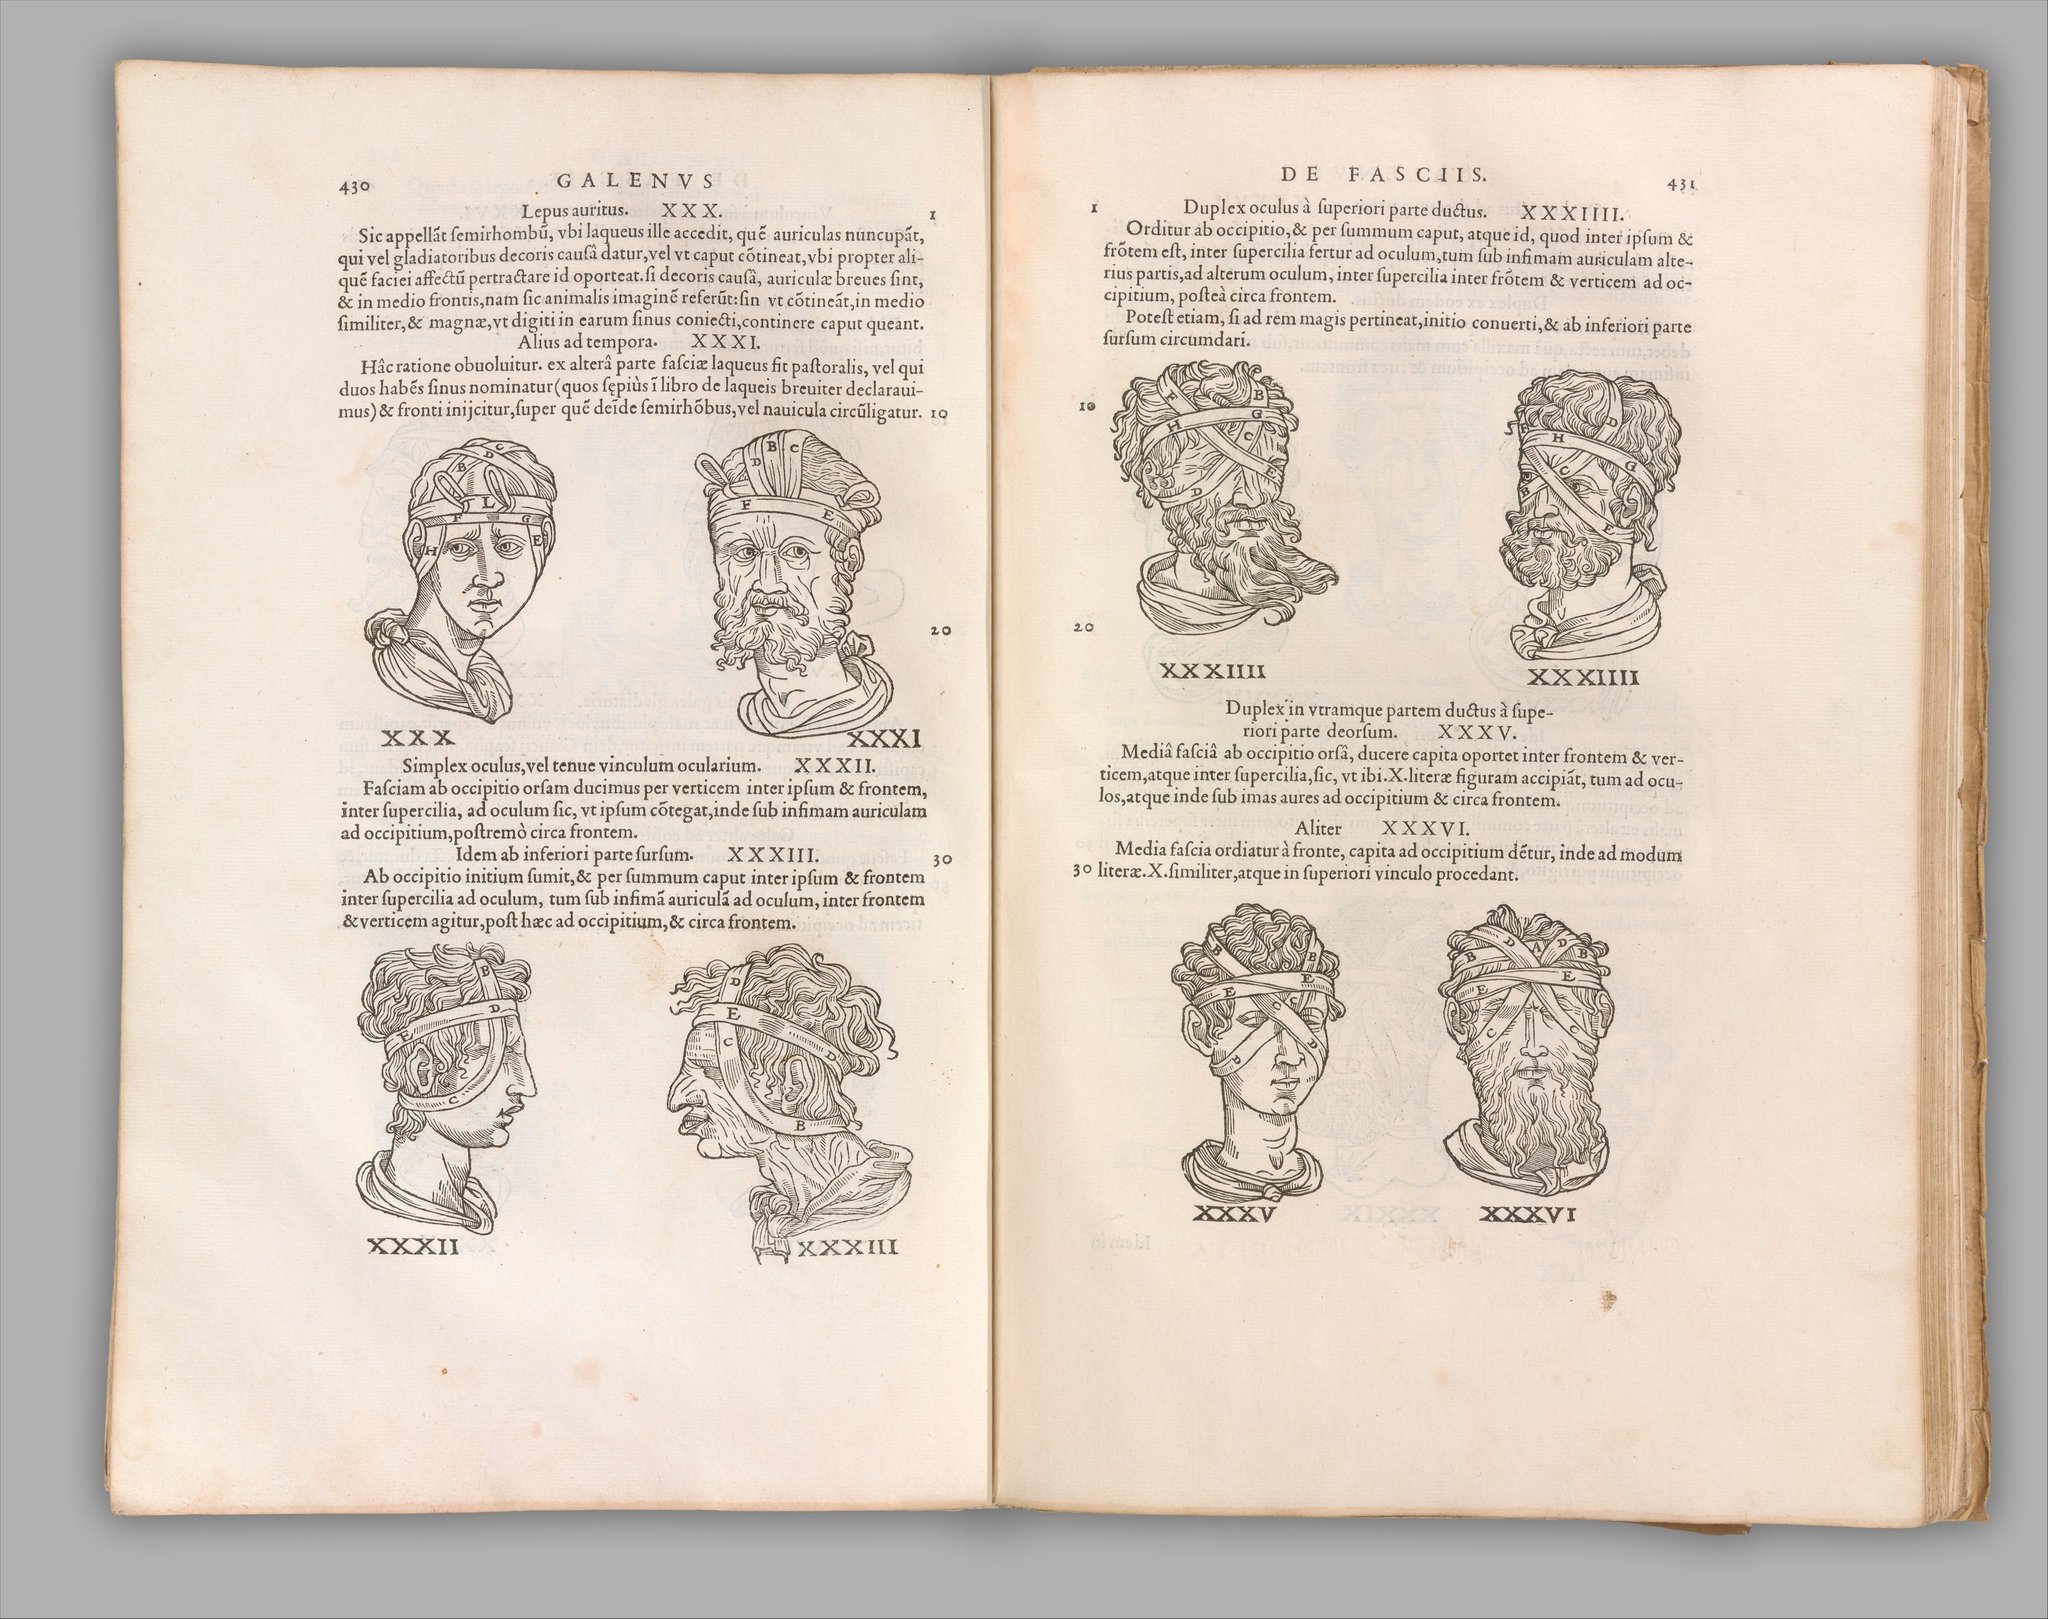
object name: book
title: Chirurgia è Graeco in Latinum conversa, Vido Vidio Florentino interprete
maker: guido guidi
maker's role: editor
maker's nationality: italian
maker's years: 1509-1569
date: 1544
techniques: printing, woodcut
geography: france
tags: heads,men,women